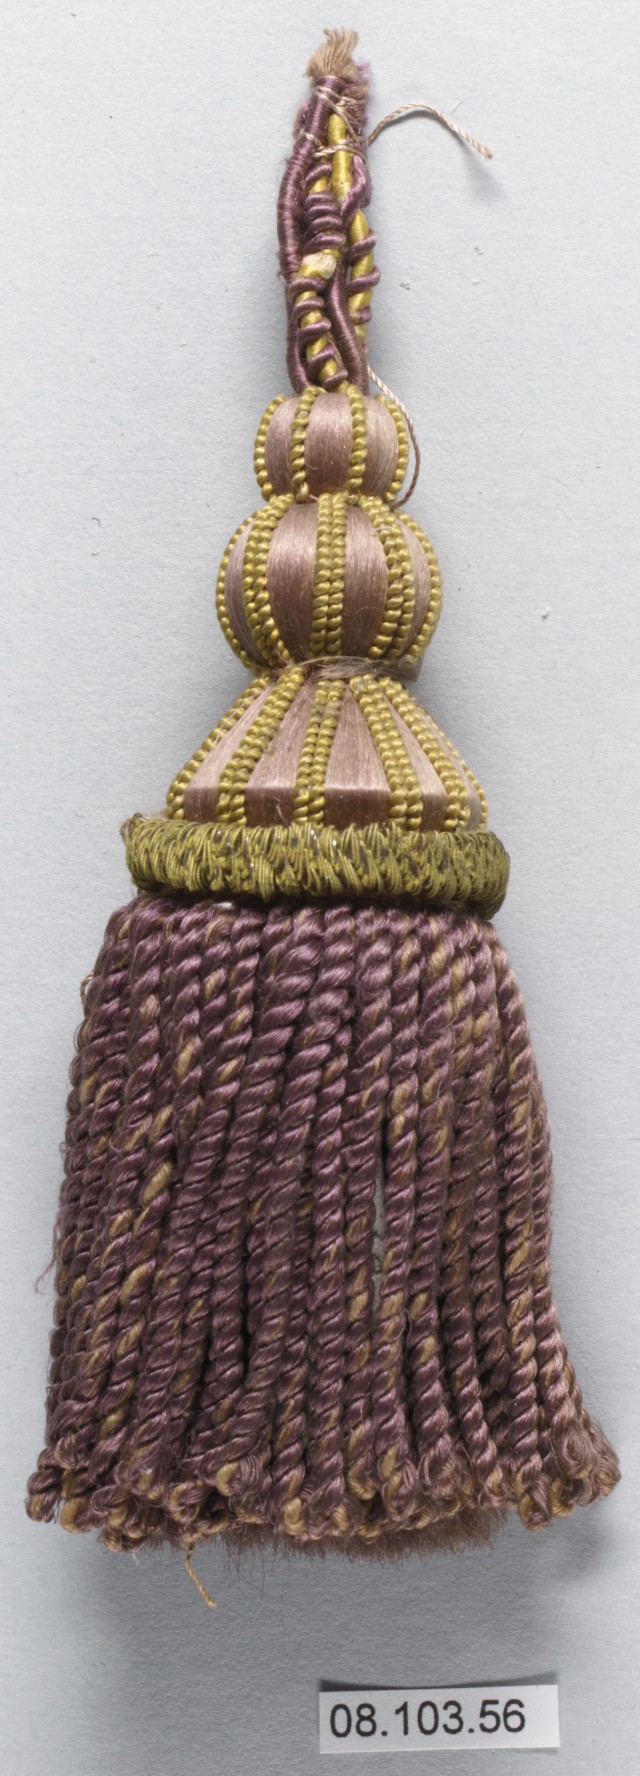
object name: tassel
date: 1801-1900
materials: metal thread, silk, wool